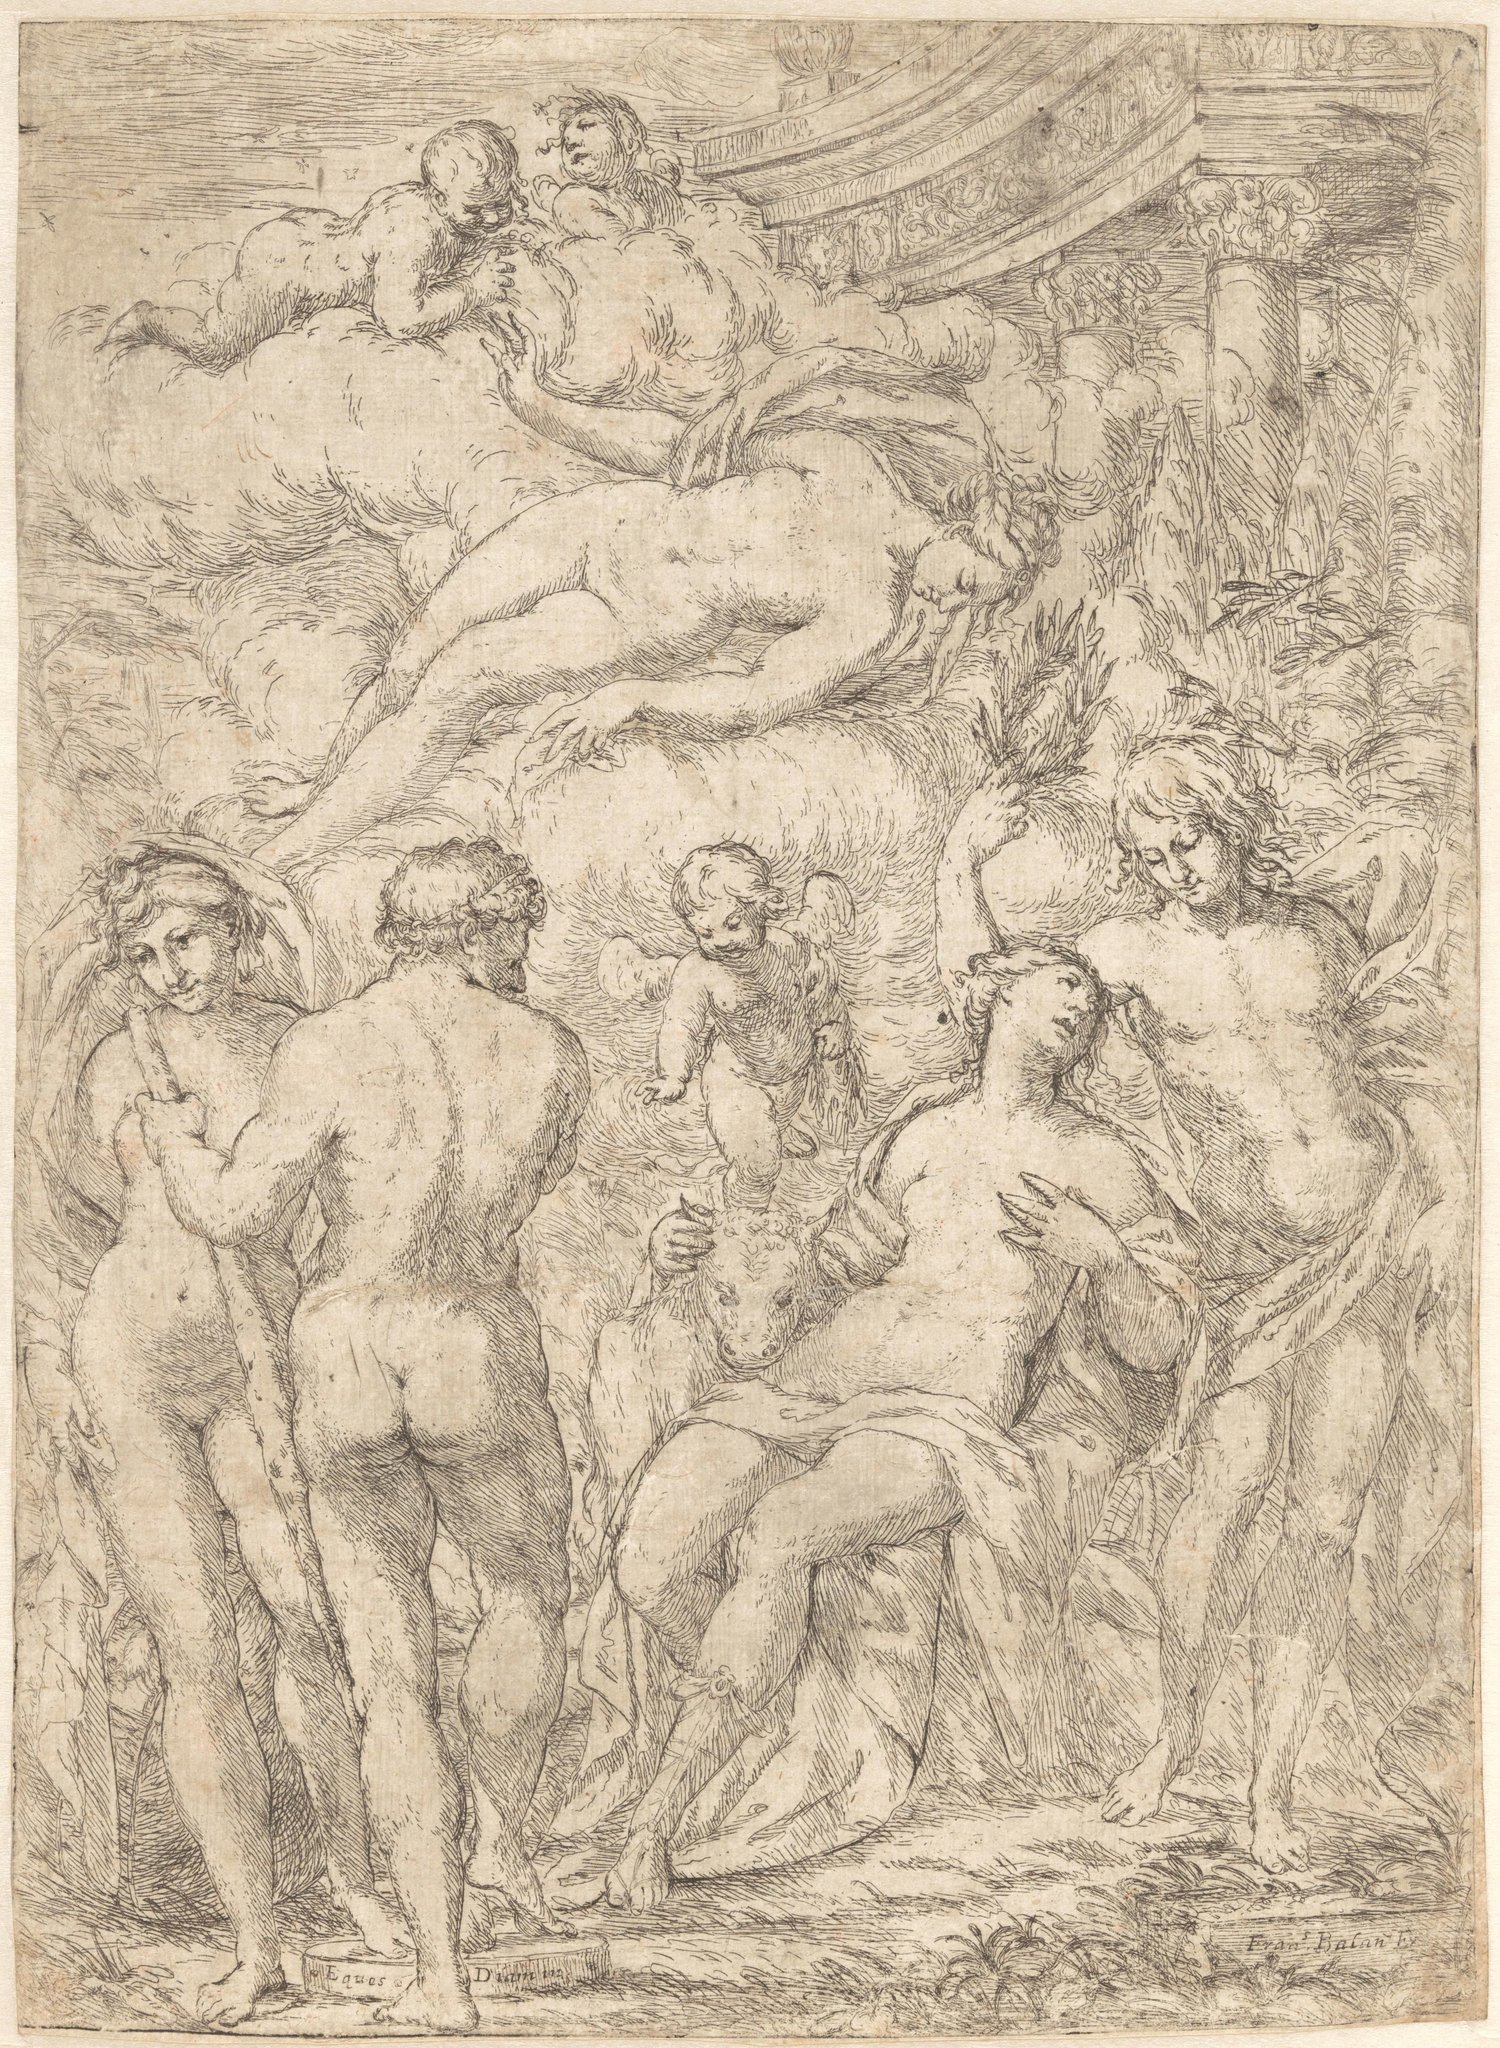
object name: print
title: Allegorie met mythologische figuren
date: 1650-1705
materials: paper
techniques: etching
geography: venice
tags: (story of) hercules (heracles), triumph of juno, crowning with laurel, assemblies of the gods (outdoors)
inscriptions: collector's mark: Lugt 2760, collector's mark: Lugt 2228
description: Mythologische scène. Een zittende vrouw (Juno?) krijgt van een staande man (Apollo?) een lauwerkrans. Links kijkt Hercules toe. Met meerdere andere figuren.